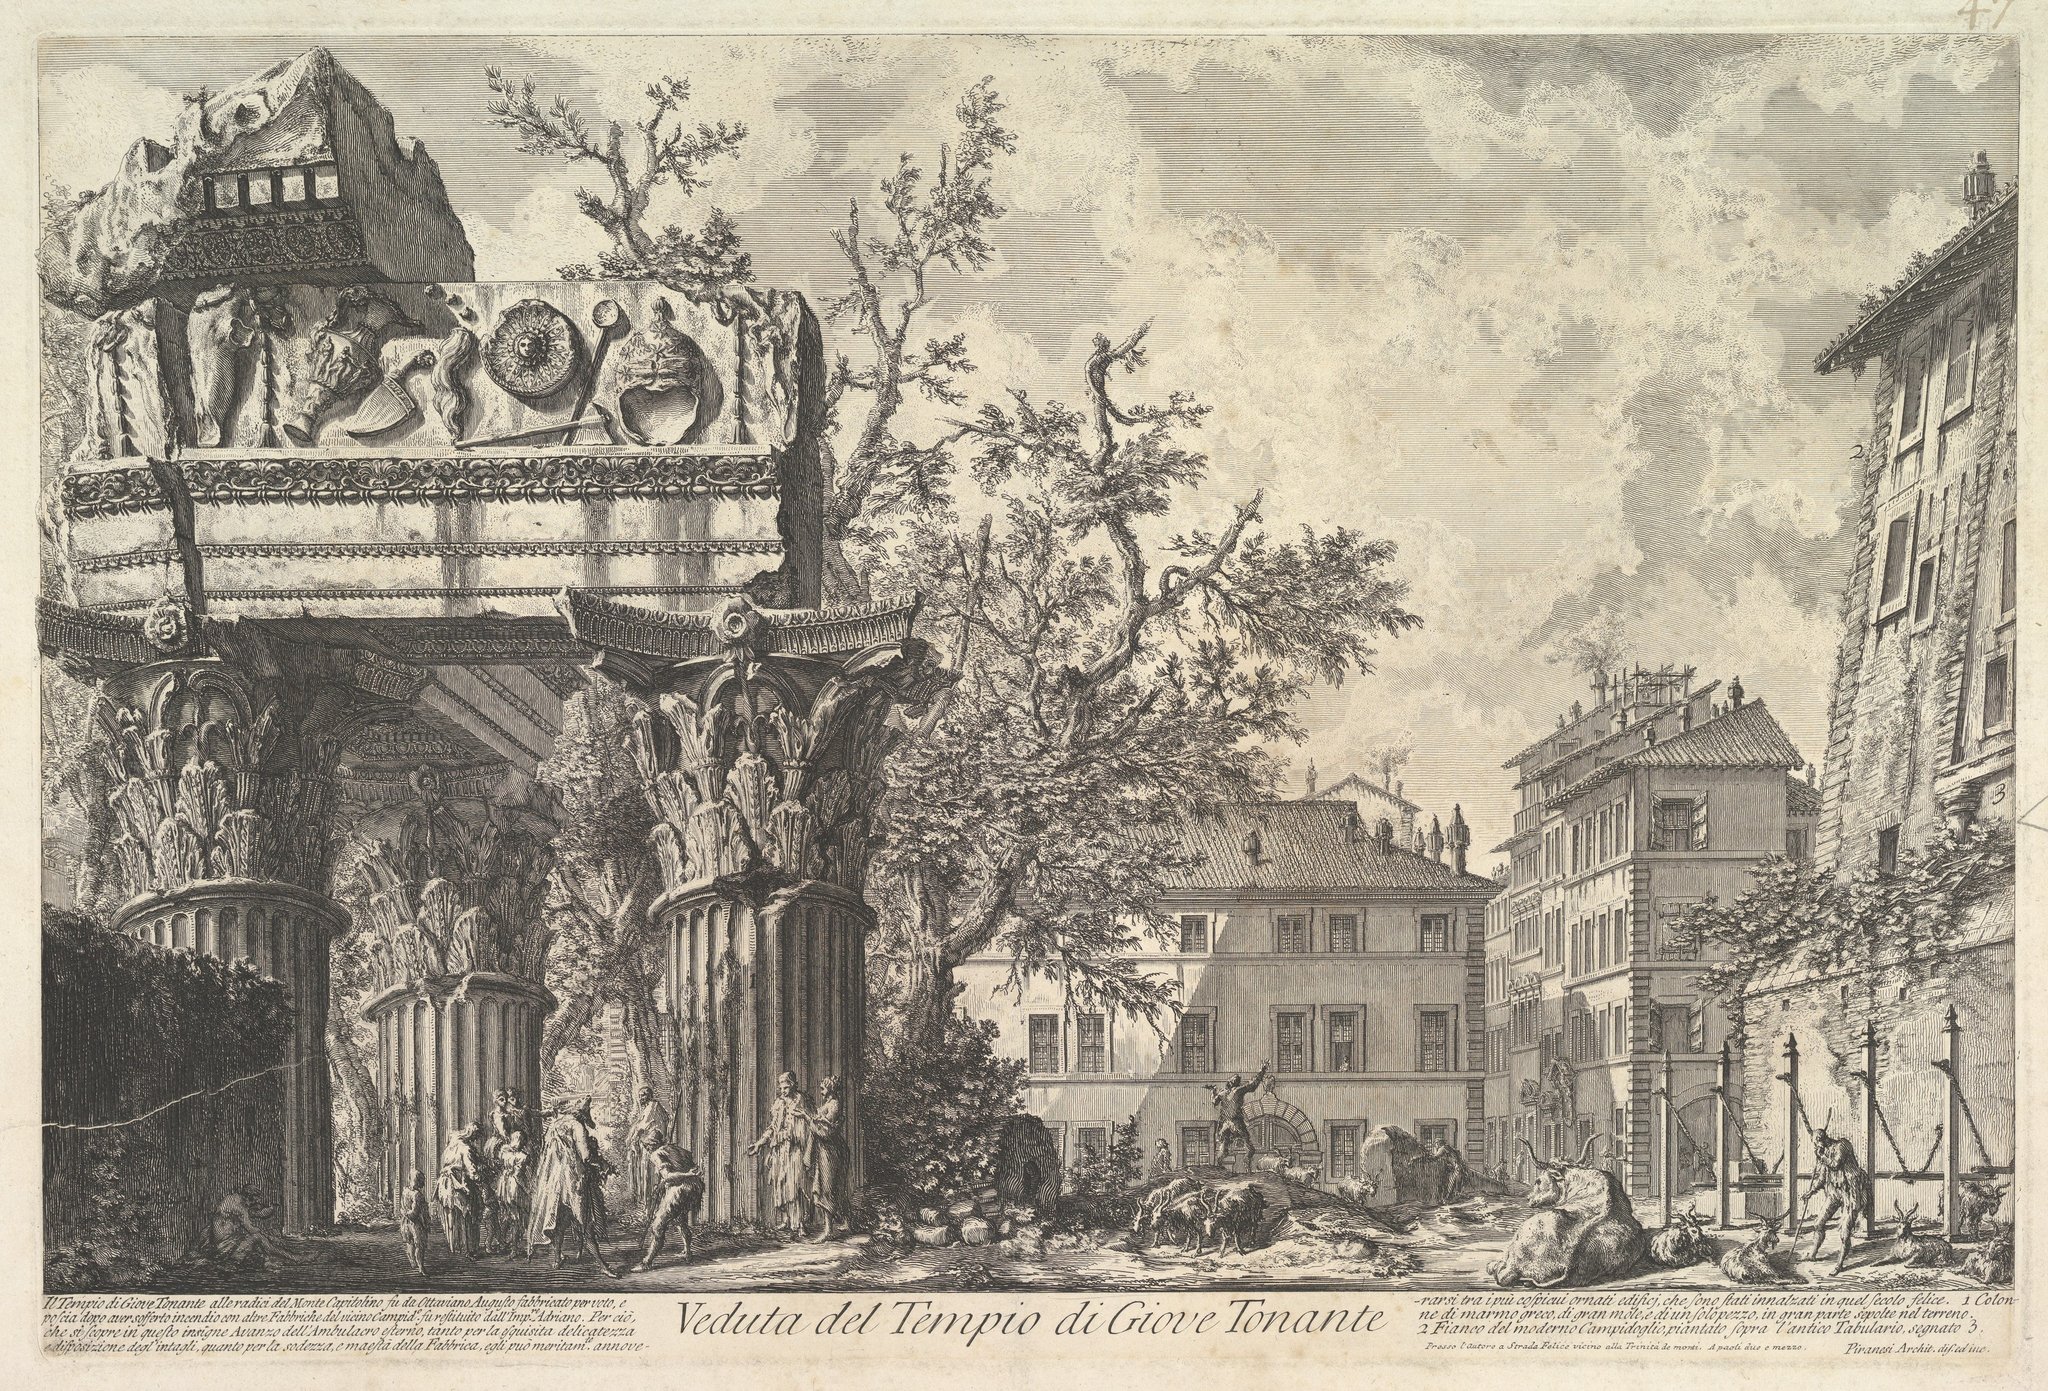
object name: print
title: The Temple of Vespian (Veduta del Tempio di giove Tonante)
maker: giovanni battista piranesi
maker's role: artist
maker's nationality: italian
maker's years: 1720-1778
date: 1756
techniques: etching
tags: human figures,buildings,temples